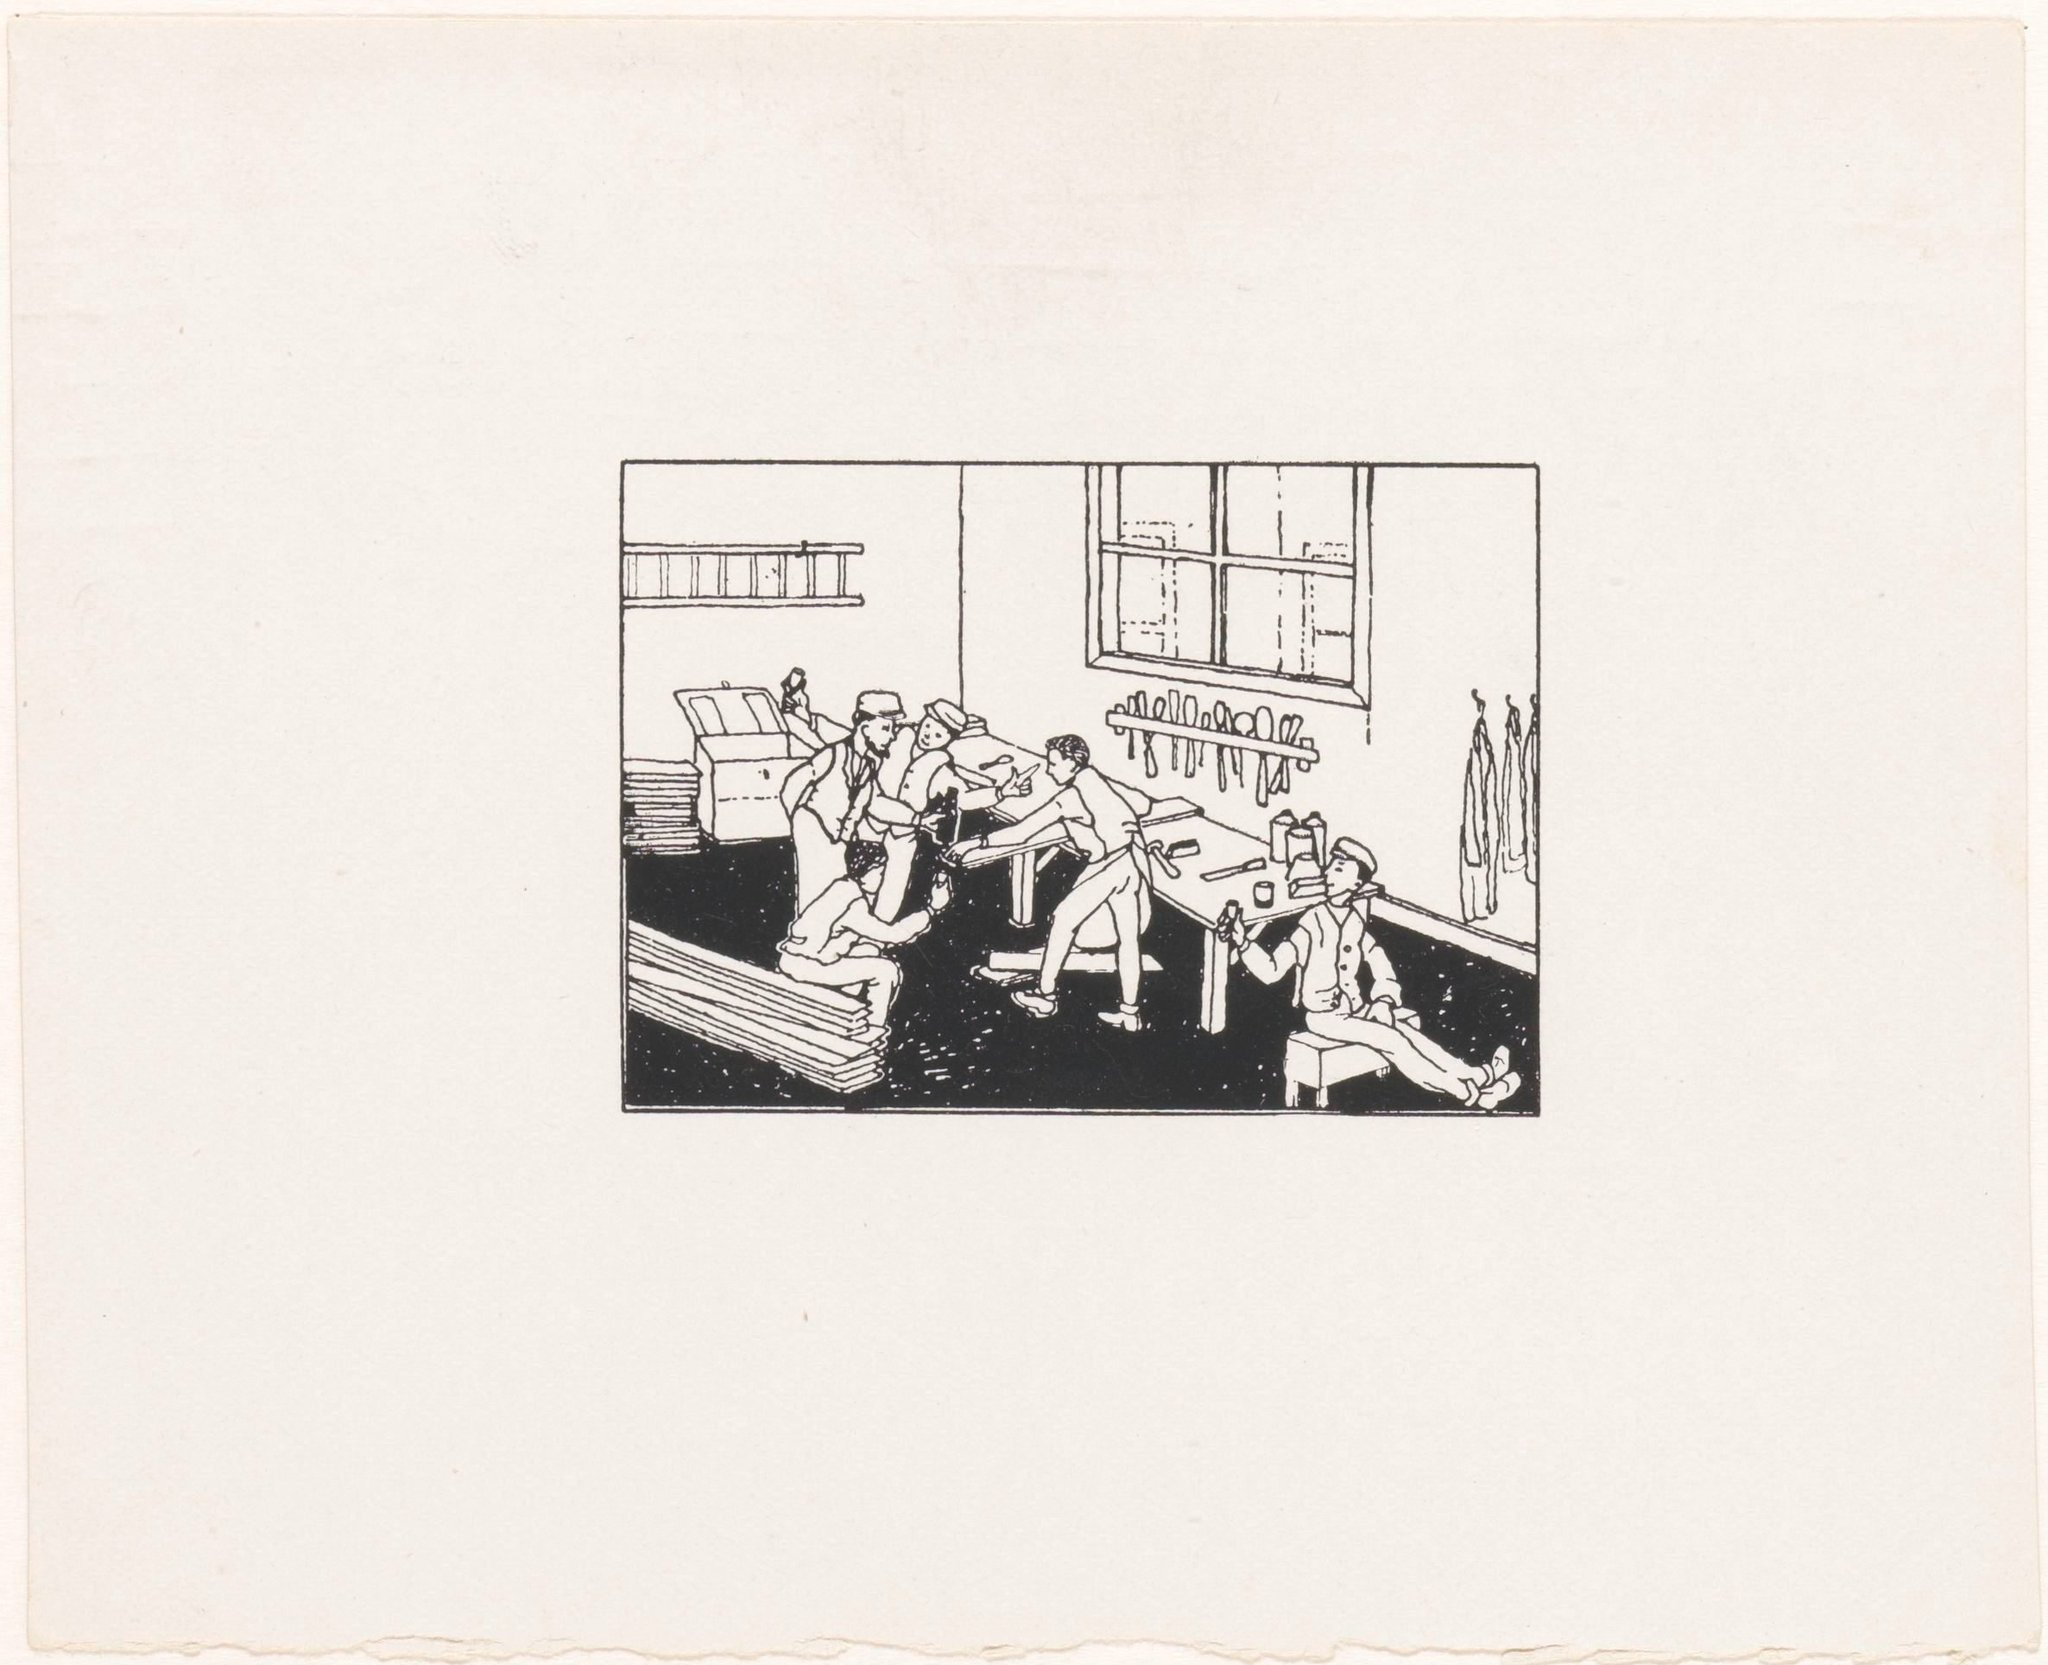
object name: print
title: Jongens bij een werkbank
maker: julie de graag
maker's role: draughtsman, print maker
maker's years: 1877-1924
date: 1878-1924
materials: paper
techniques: line block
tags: tools, aids, implements ~ crafts and industries, boy (child between toddler and youth)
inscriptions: collector's mark: Lugt 2228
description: Aan de muur hangt gereedschap. Op de grond ligt een stapel planken.